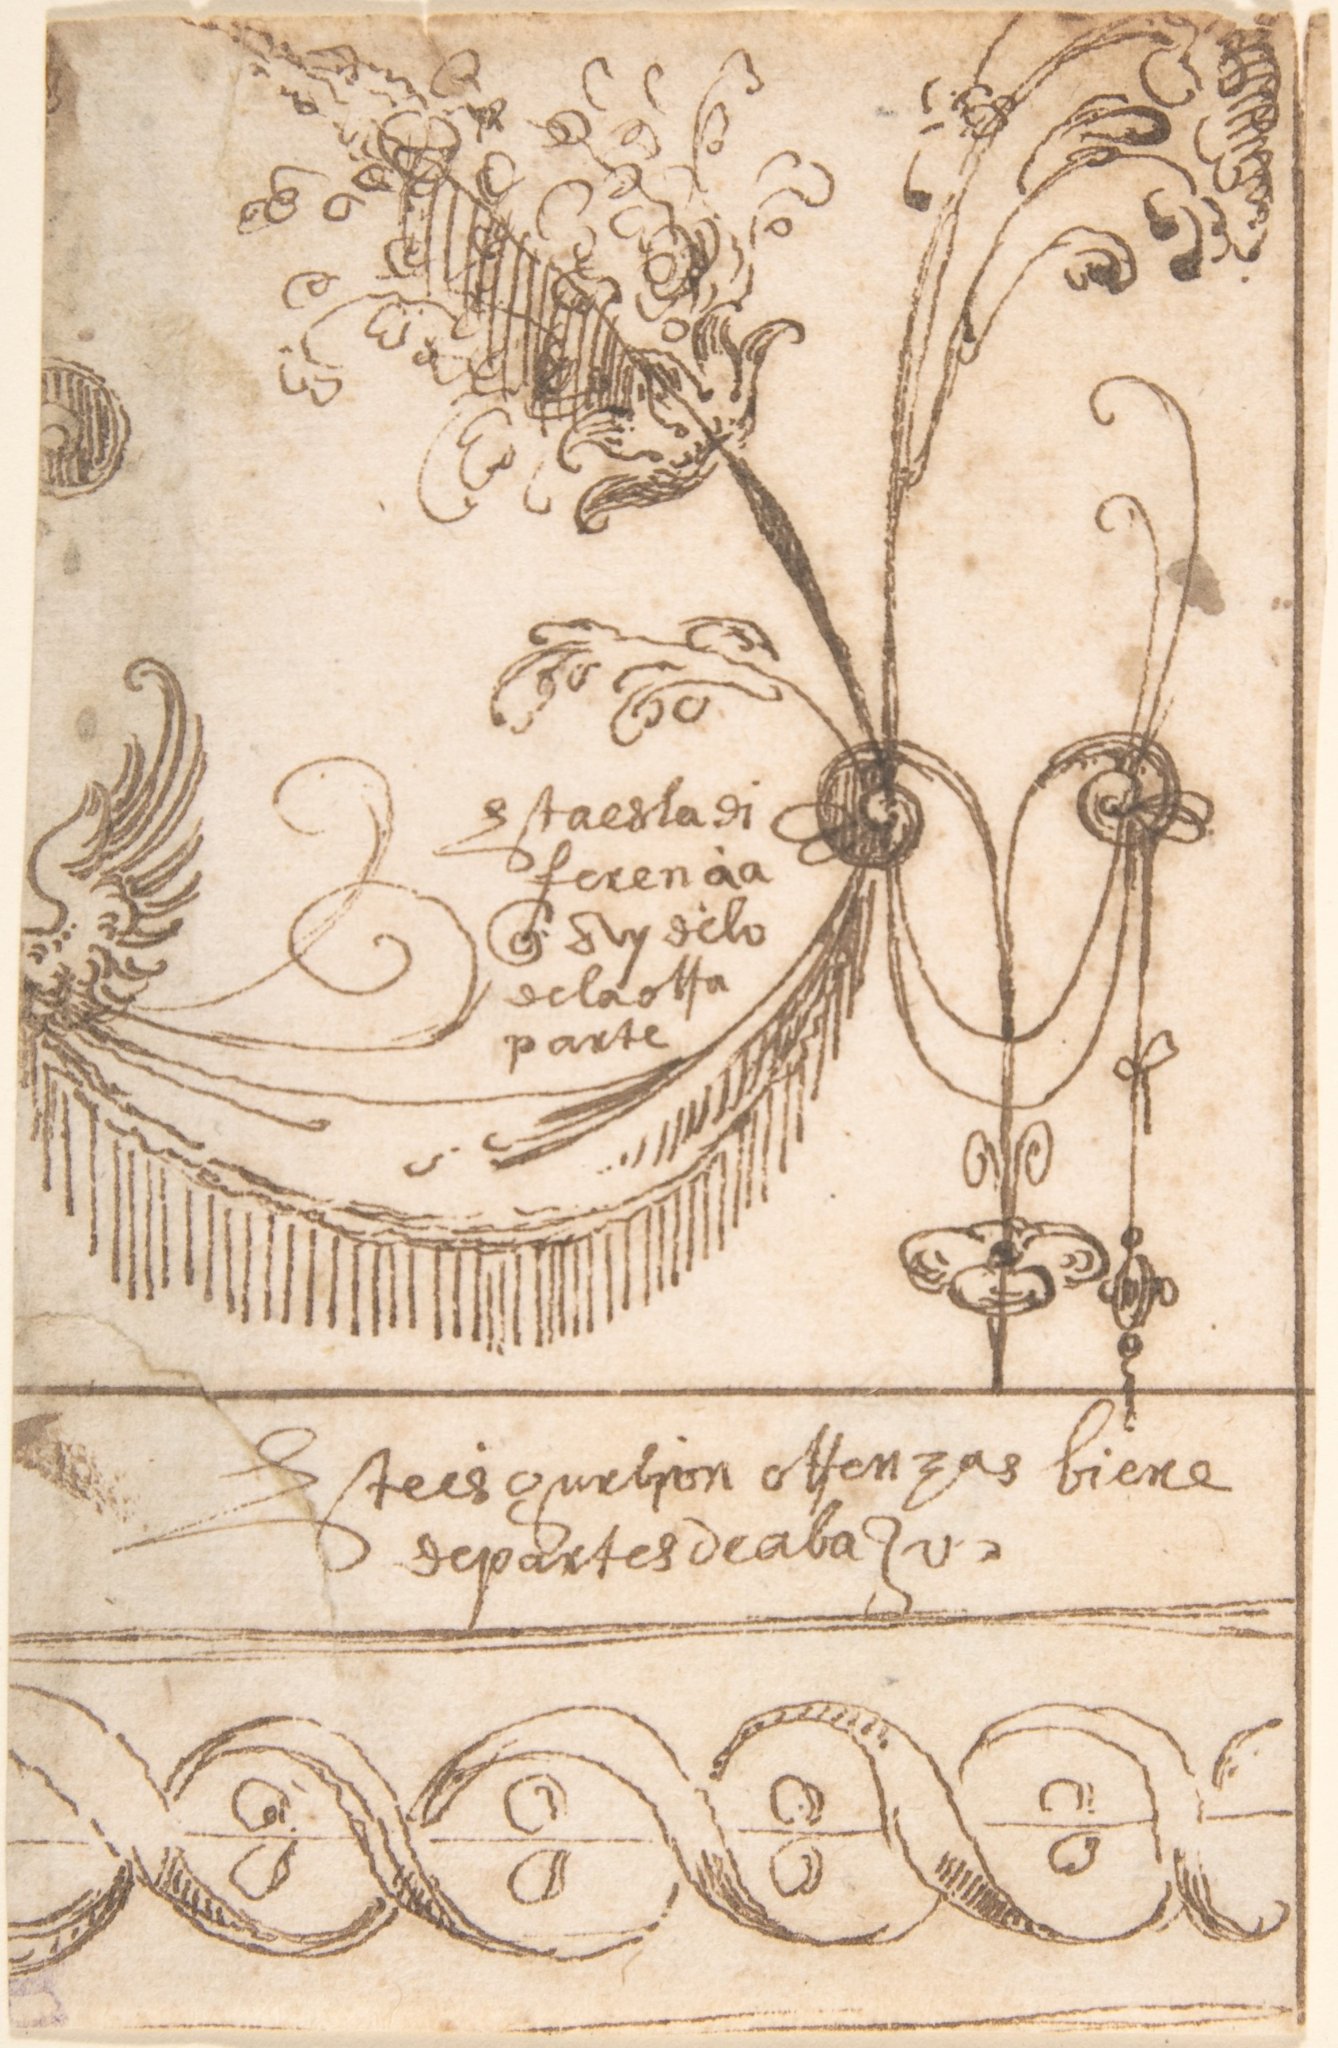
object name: drawing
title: Grotesque ornament comprising a swag and a repeated band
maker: andrés de melgar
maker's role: artist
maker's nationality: spanish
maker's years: 1554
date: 1545-1560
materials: ink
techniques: pen